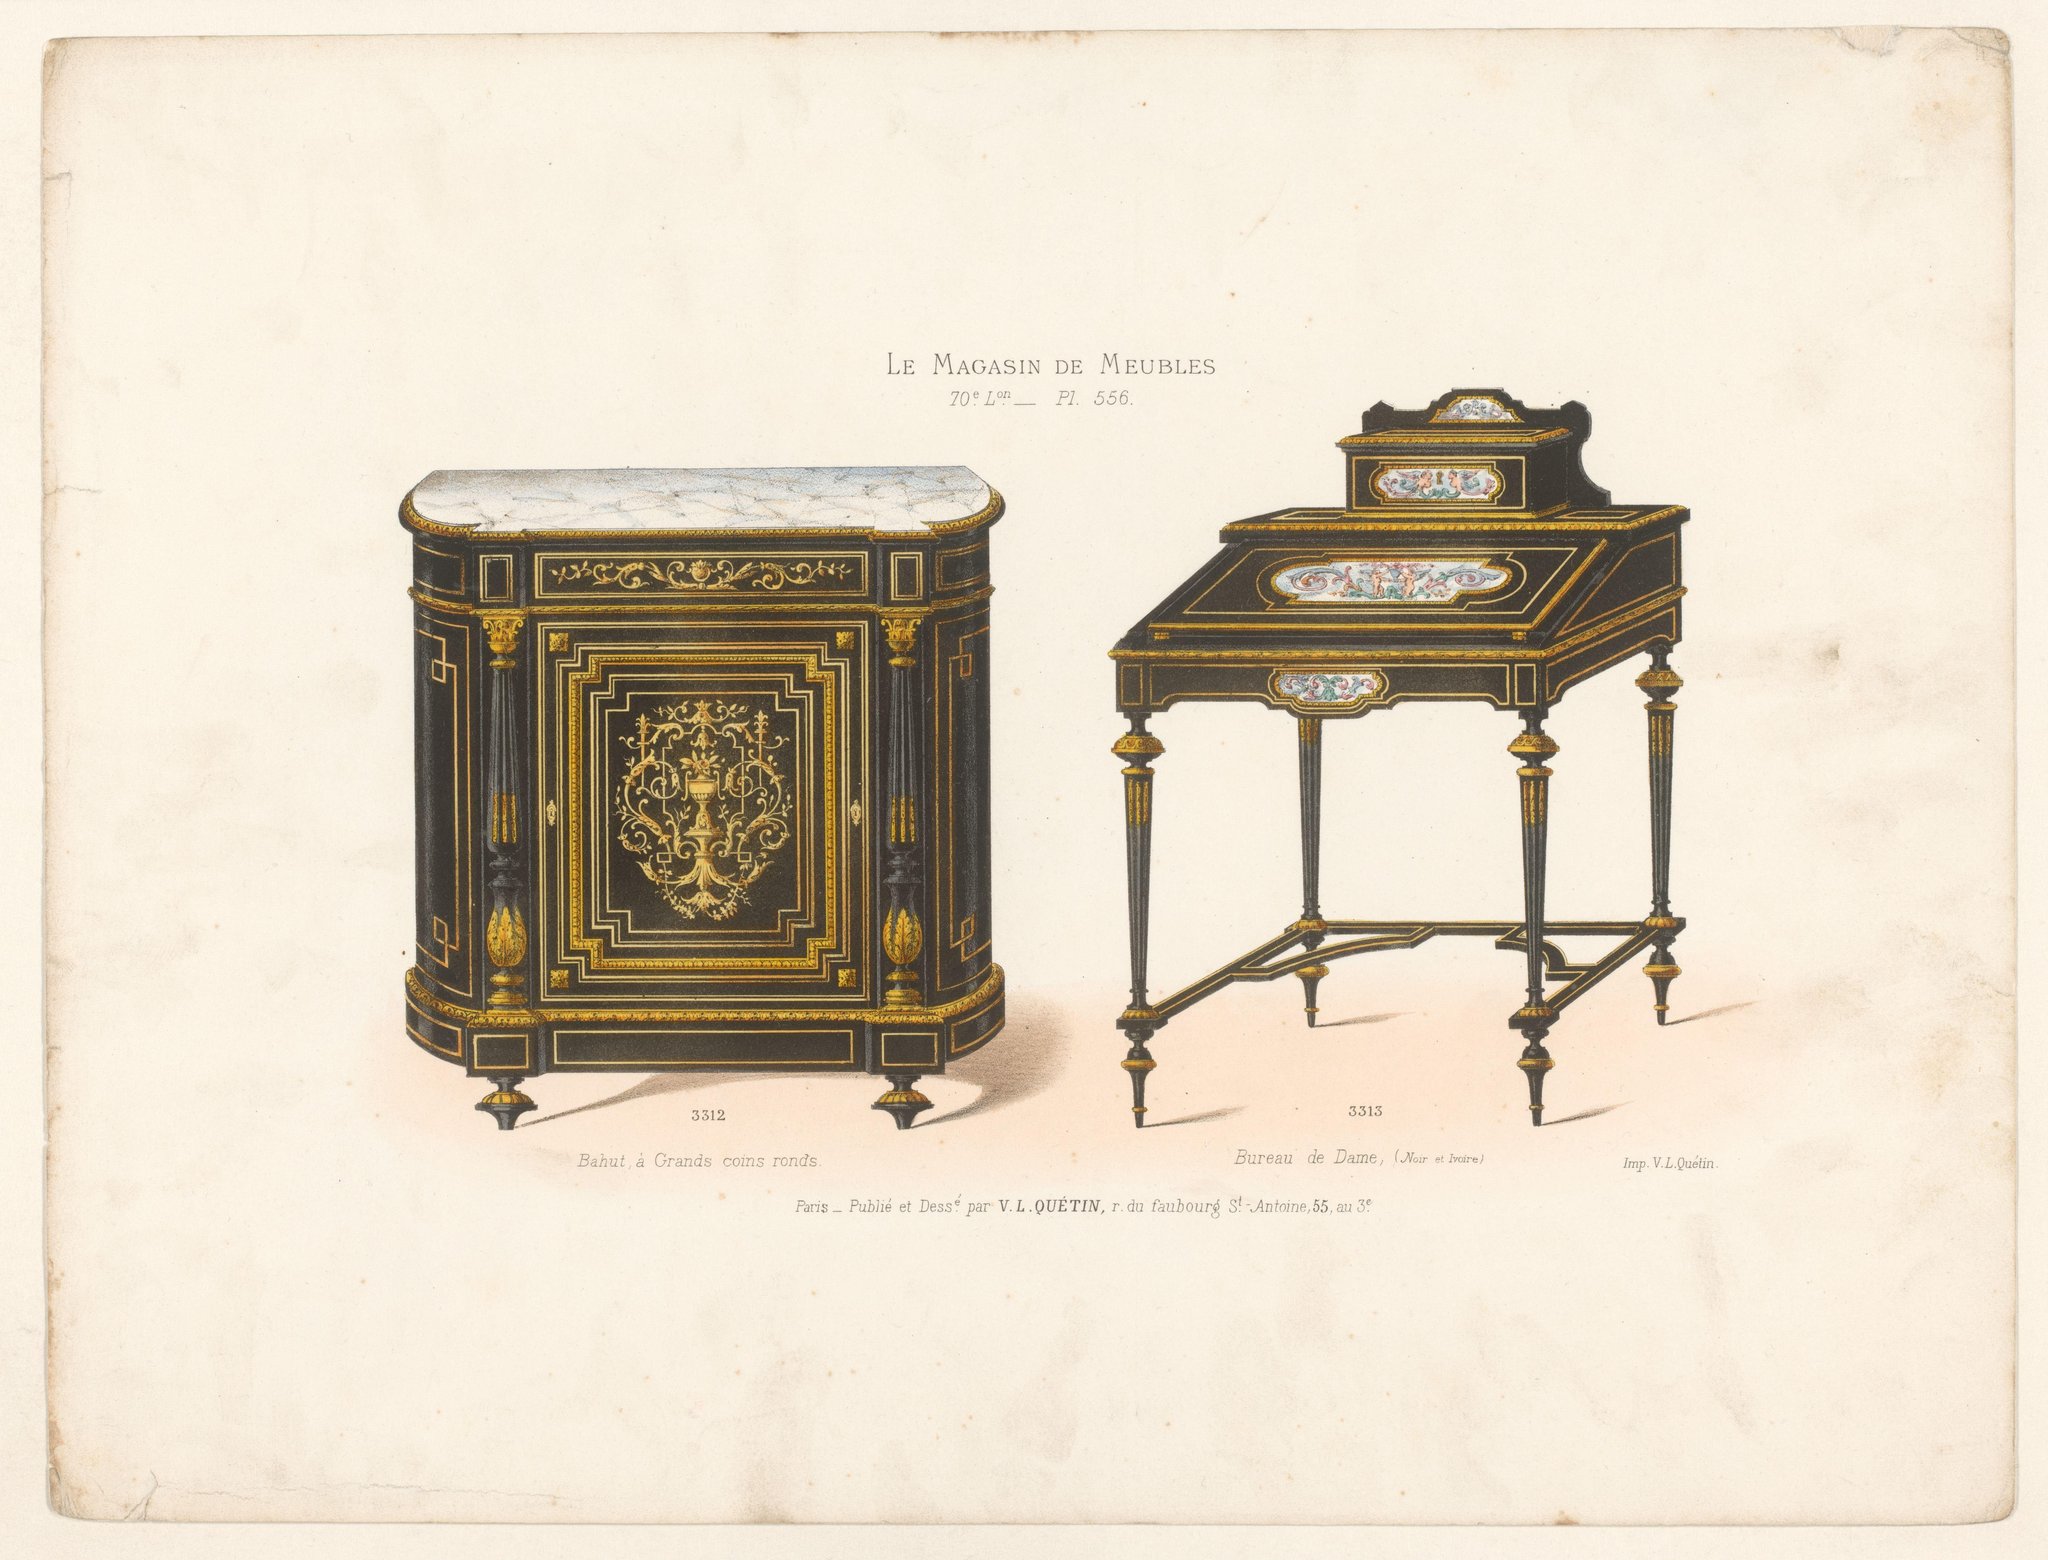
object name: print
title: Bahut à Grands coins ronds / Bureau de Dame, (Noir et Ivoire)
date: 1878-1904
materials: paper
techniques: hand coloring, lithograph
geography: paris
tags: writing-table, writing-desk, furniture for storage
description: Een lage kast en damesbureau. Prent uit 70e Livraison.